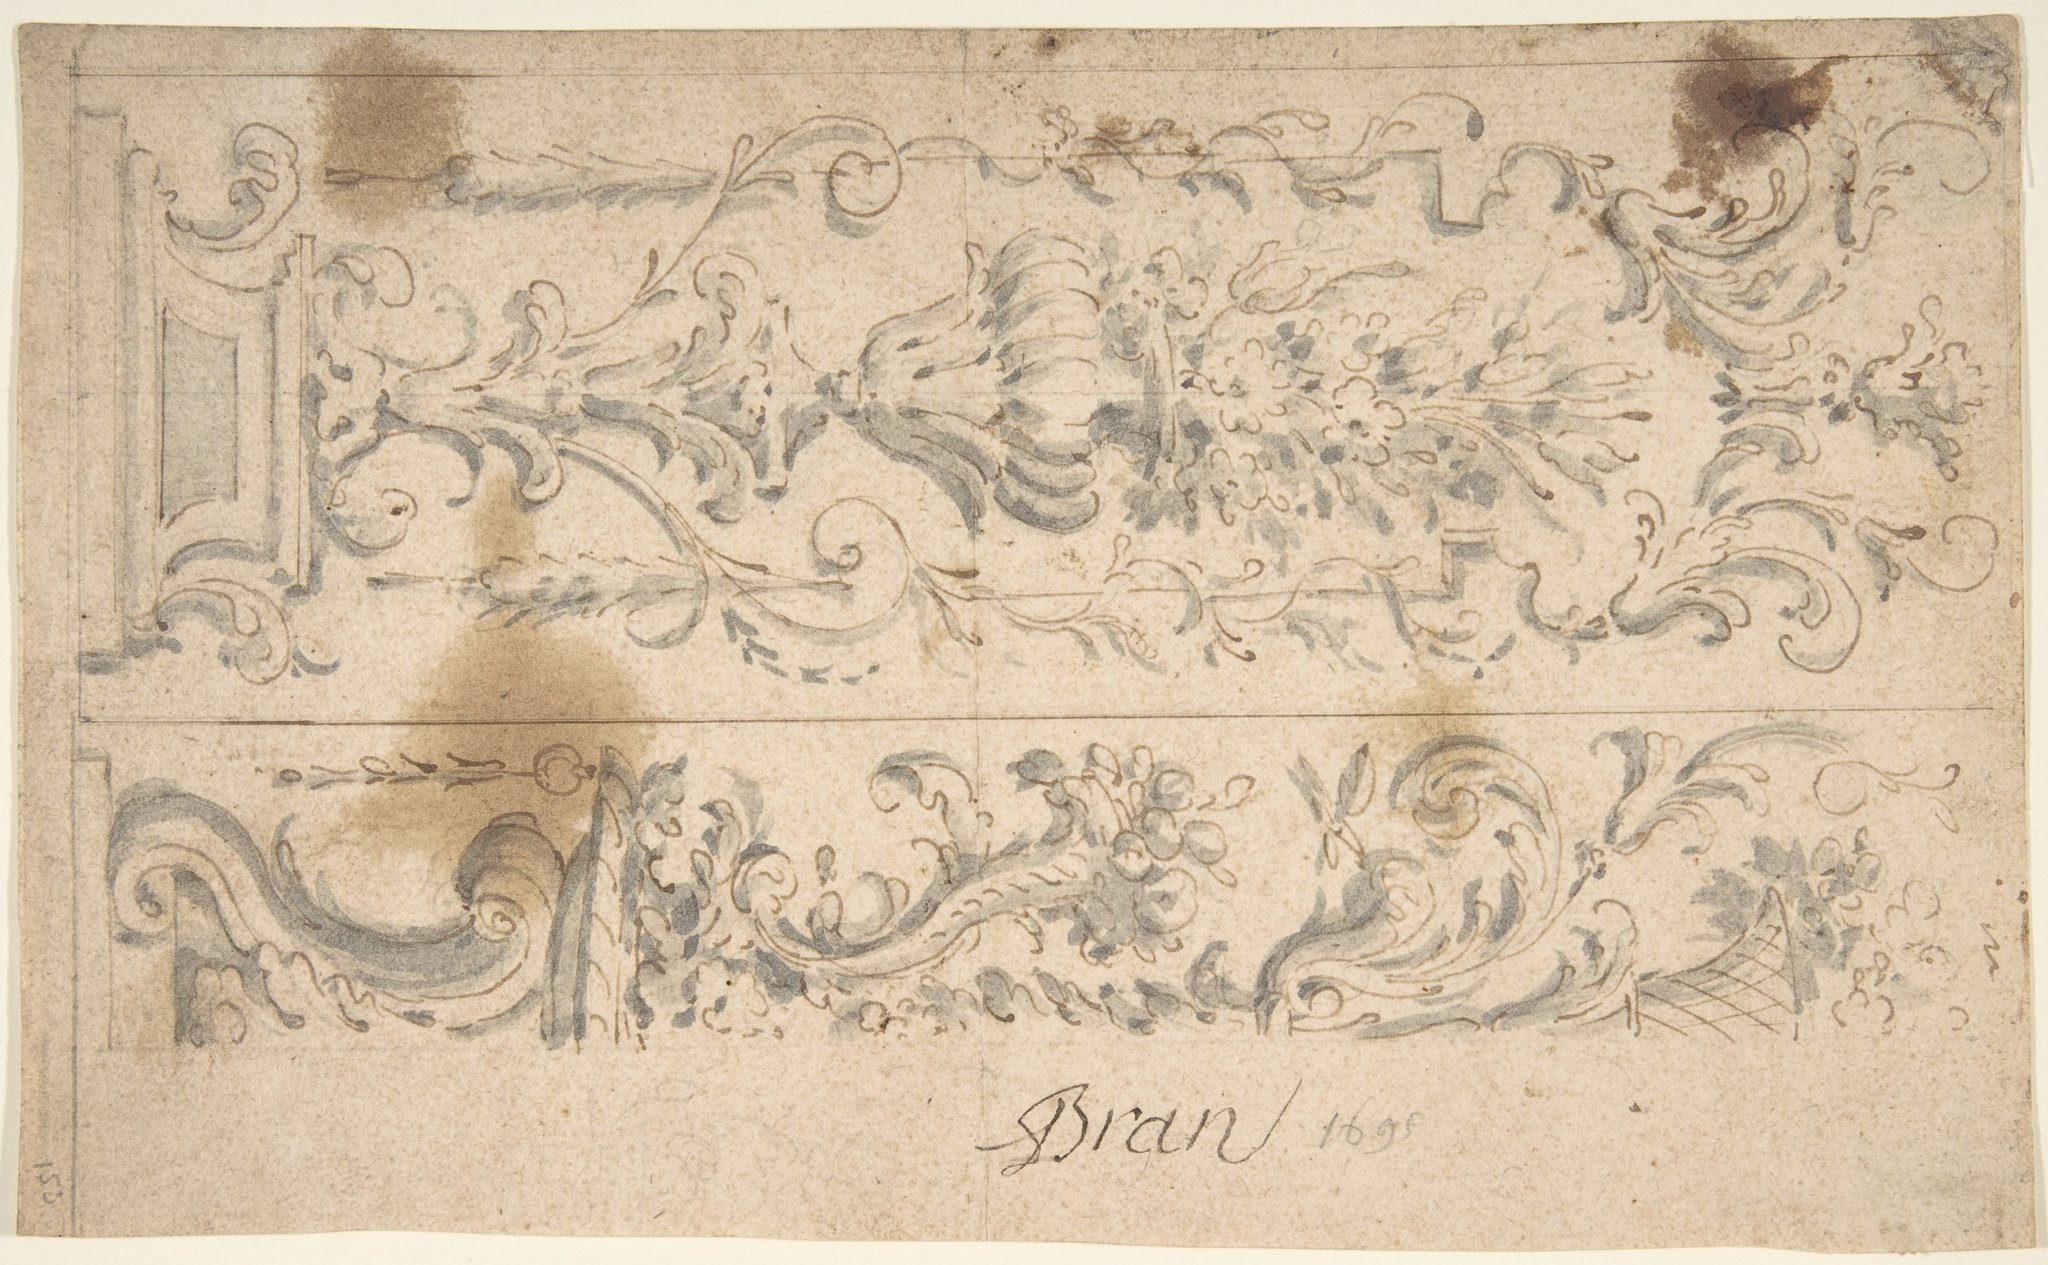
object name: drawing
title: Two Designs for Floral Panels of Ornament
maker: anonymous, italian, piedmontese, 18th century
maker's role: artist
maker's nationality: italian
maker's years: 1700-1800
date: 1680-1780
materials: graphite, ink, drawing material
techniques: brush, pen, wash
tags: ornament